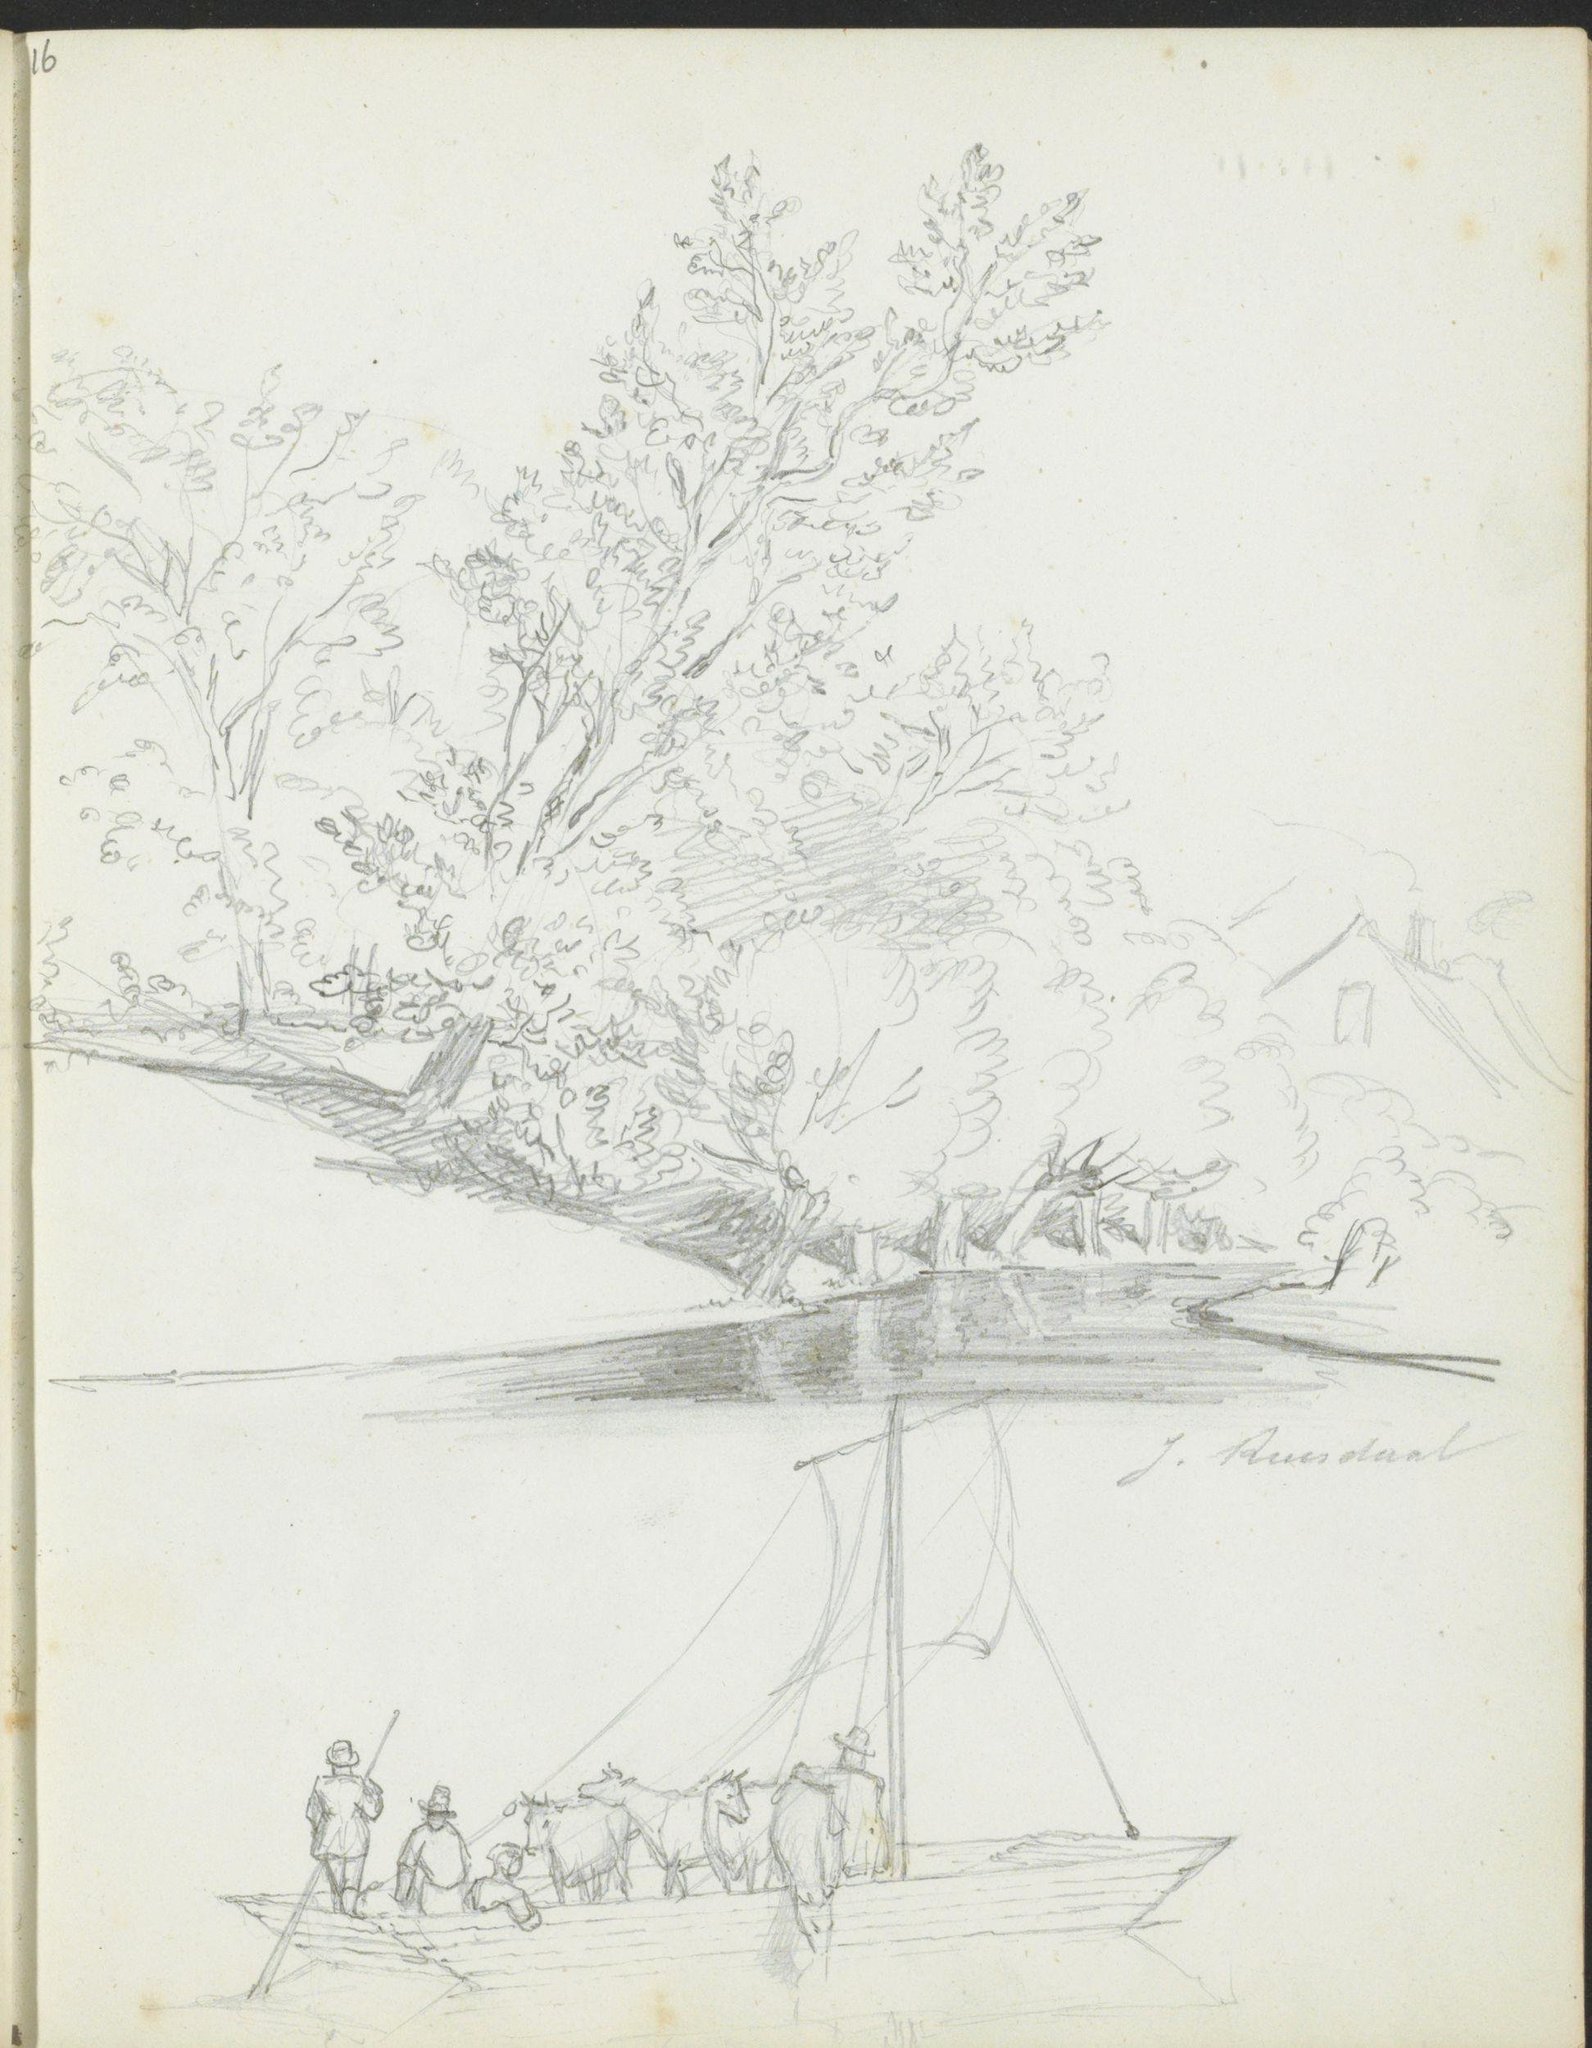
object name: sketchbook leaf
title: Bomen aan een waterkant en een boot met vee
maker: hendrik abraham klinkhamer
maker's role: draughtsman, painter, print maker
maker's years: 1810-1872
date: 1820-1872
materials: paper, pencil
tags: cattle, landscapes with waters, waterscapes, seascapes (in the temperate zone), boat propelled by man or animal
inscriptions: annotation: ‘J. Ruisdaal’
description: Blad 16 recto uit een schetsboek met 21 bladen.